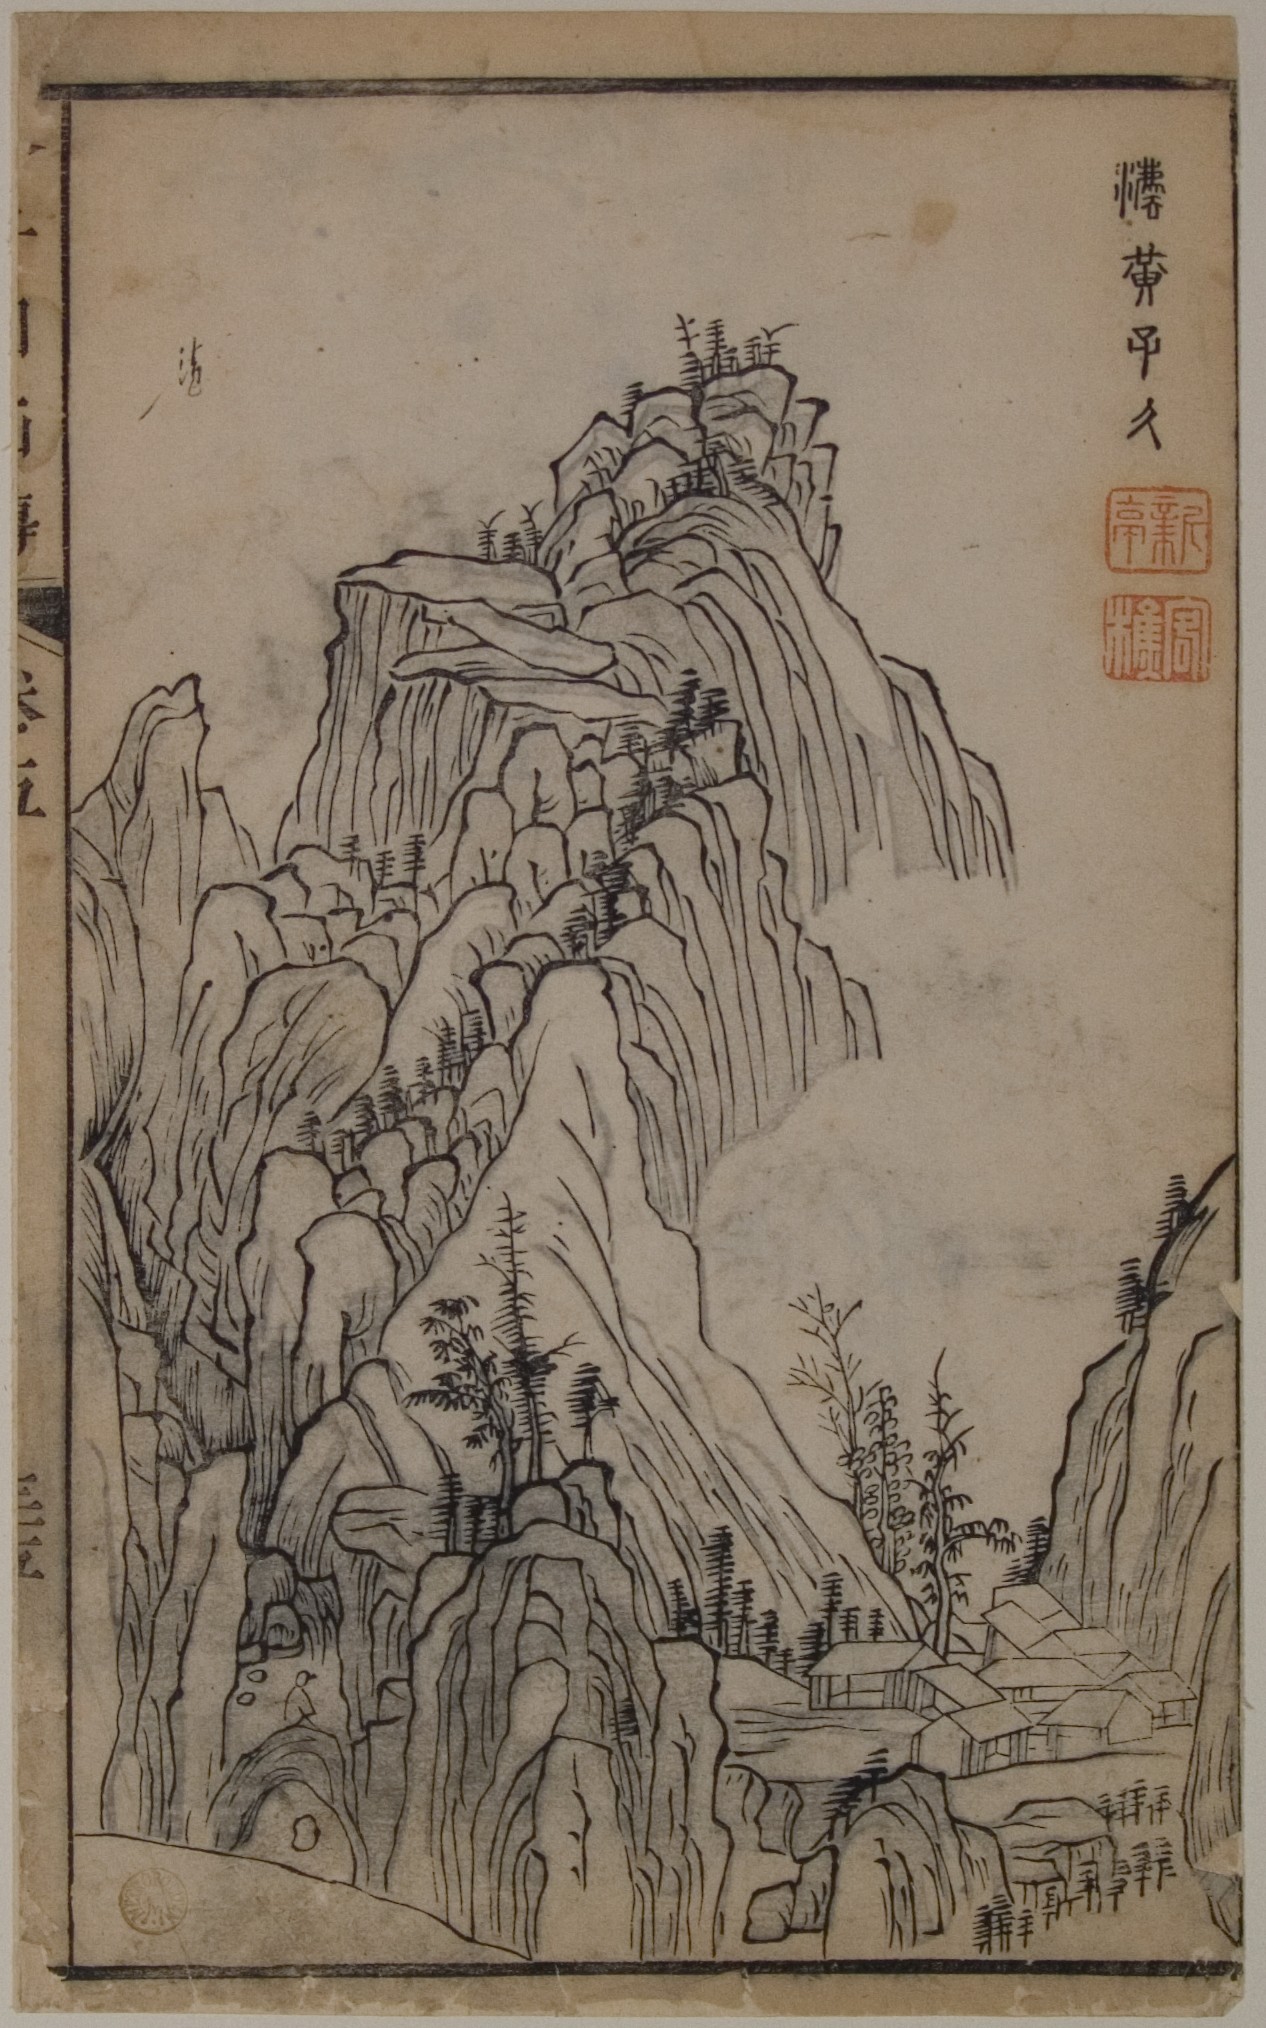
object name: print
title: A Page from the Jie Zi Yuan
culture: chinese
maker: huang zujiu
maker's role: artist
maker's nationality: chinese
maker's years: 1269-1354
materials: ink, paper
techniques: polychrome, woodblock print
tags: mountains